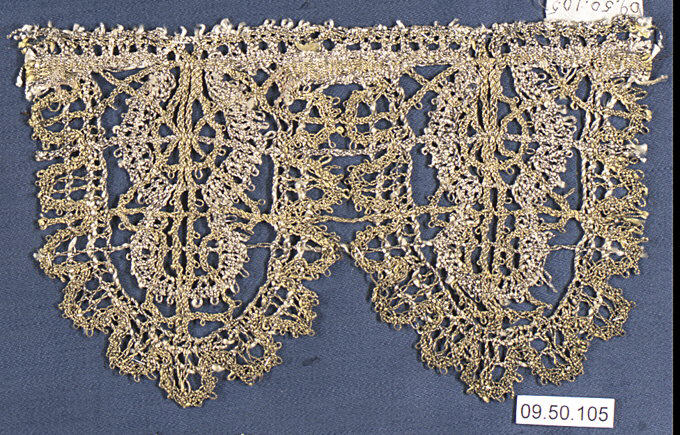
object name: fragment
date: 1601-1700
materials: metal thread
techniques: lace